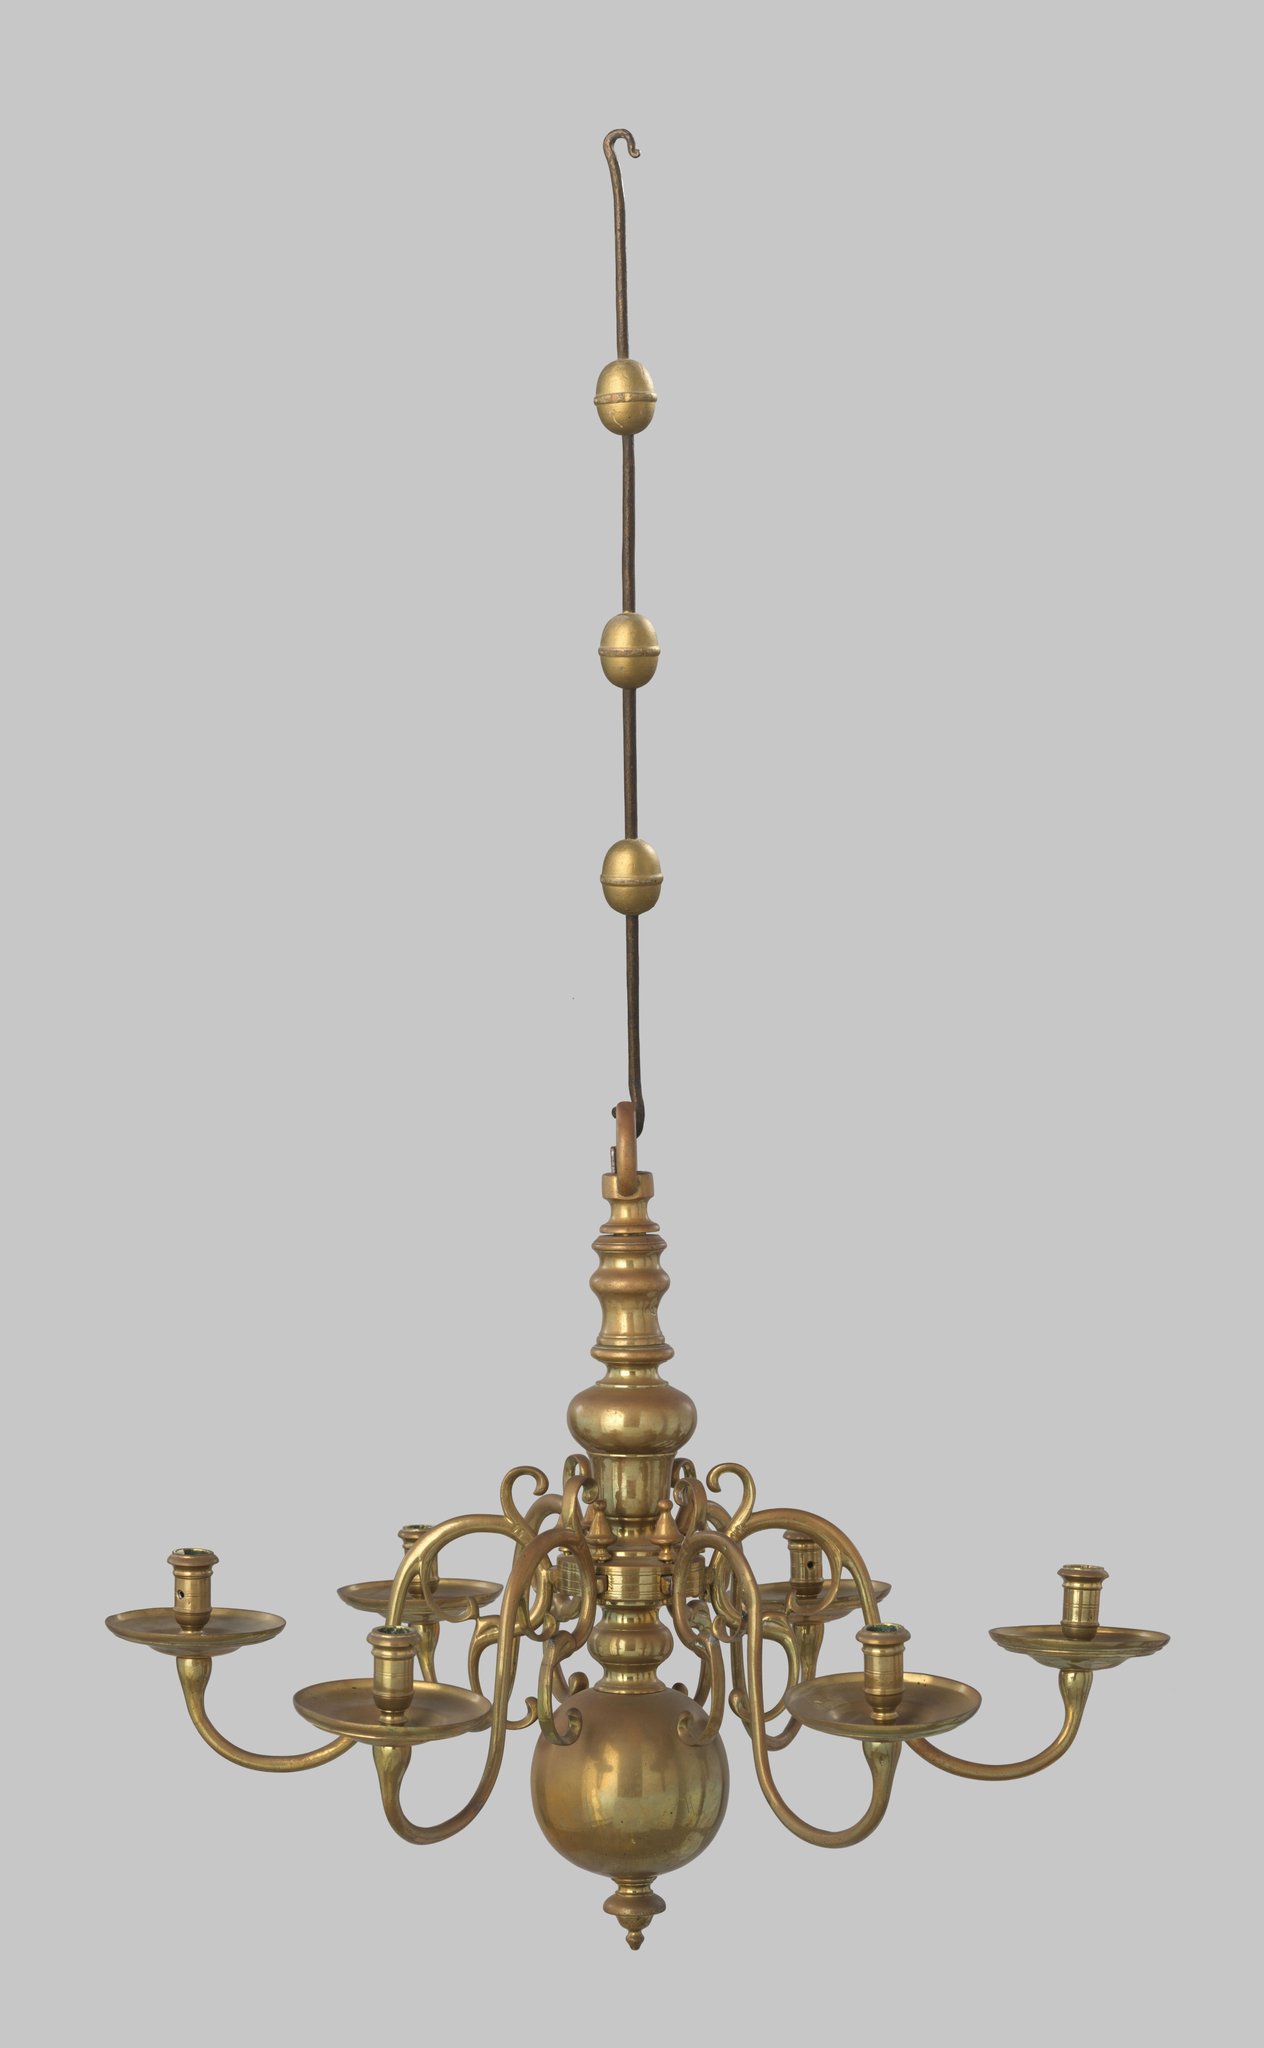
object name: chandelier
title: Arm van een kaarsenkroon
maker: Anonymous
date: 1700-1800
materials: brass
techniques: casting, screwed, turning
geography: northern netherlands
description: De S-vormige arm loopt naar de stam toe uit in een gestileerde dolfijnenkop en naar buiten toe in een verdikking, waarin het schroefgat is aangebracht. Daarop is de ronde geprofileerde en met gegroefde ringen versierde kaarsenhouder met de aan de onderkant geprofileerde en met gegroefde ringen versierde vetvanger geschroefd. De arm, de vetvanger en de kaarsenhouder zijn met behulp van dezelfde modellen gegoten als de overige armen, vetvangers en kaarsenhouders. Dit is de zesde arm van de middelste standring, niet gemarkeerd.